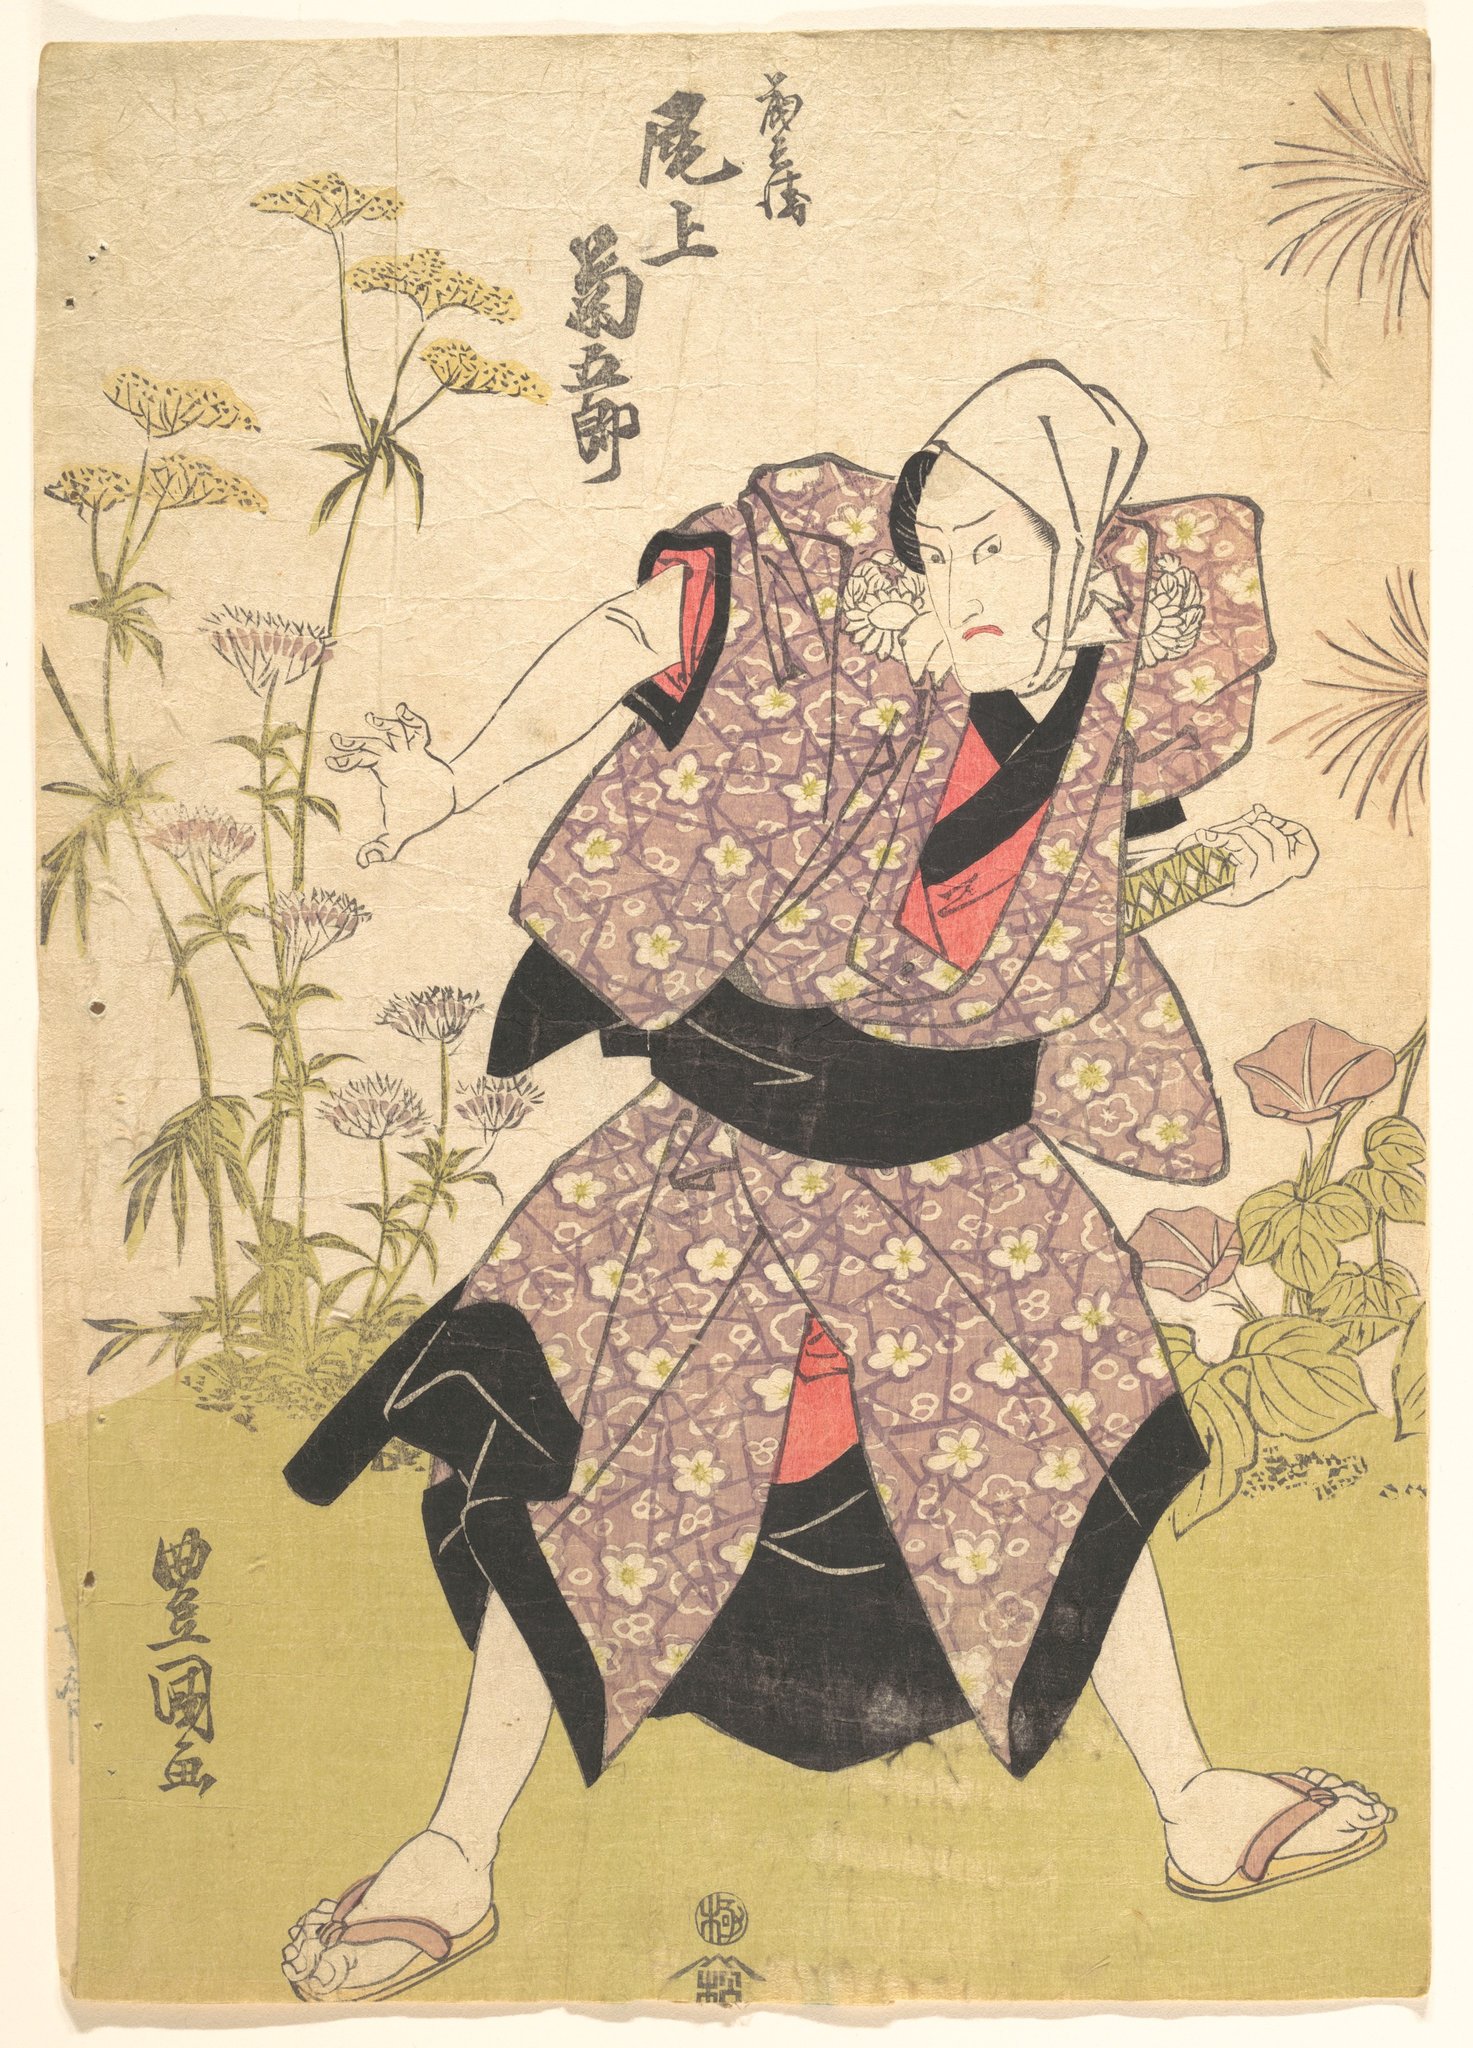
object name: print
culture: japanese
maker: utagawa kunisada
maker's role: artist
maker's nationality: japanese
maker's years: 1786-1864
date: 1801-1900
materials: ink, paper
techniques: woodblock print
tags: men,flowers